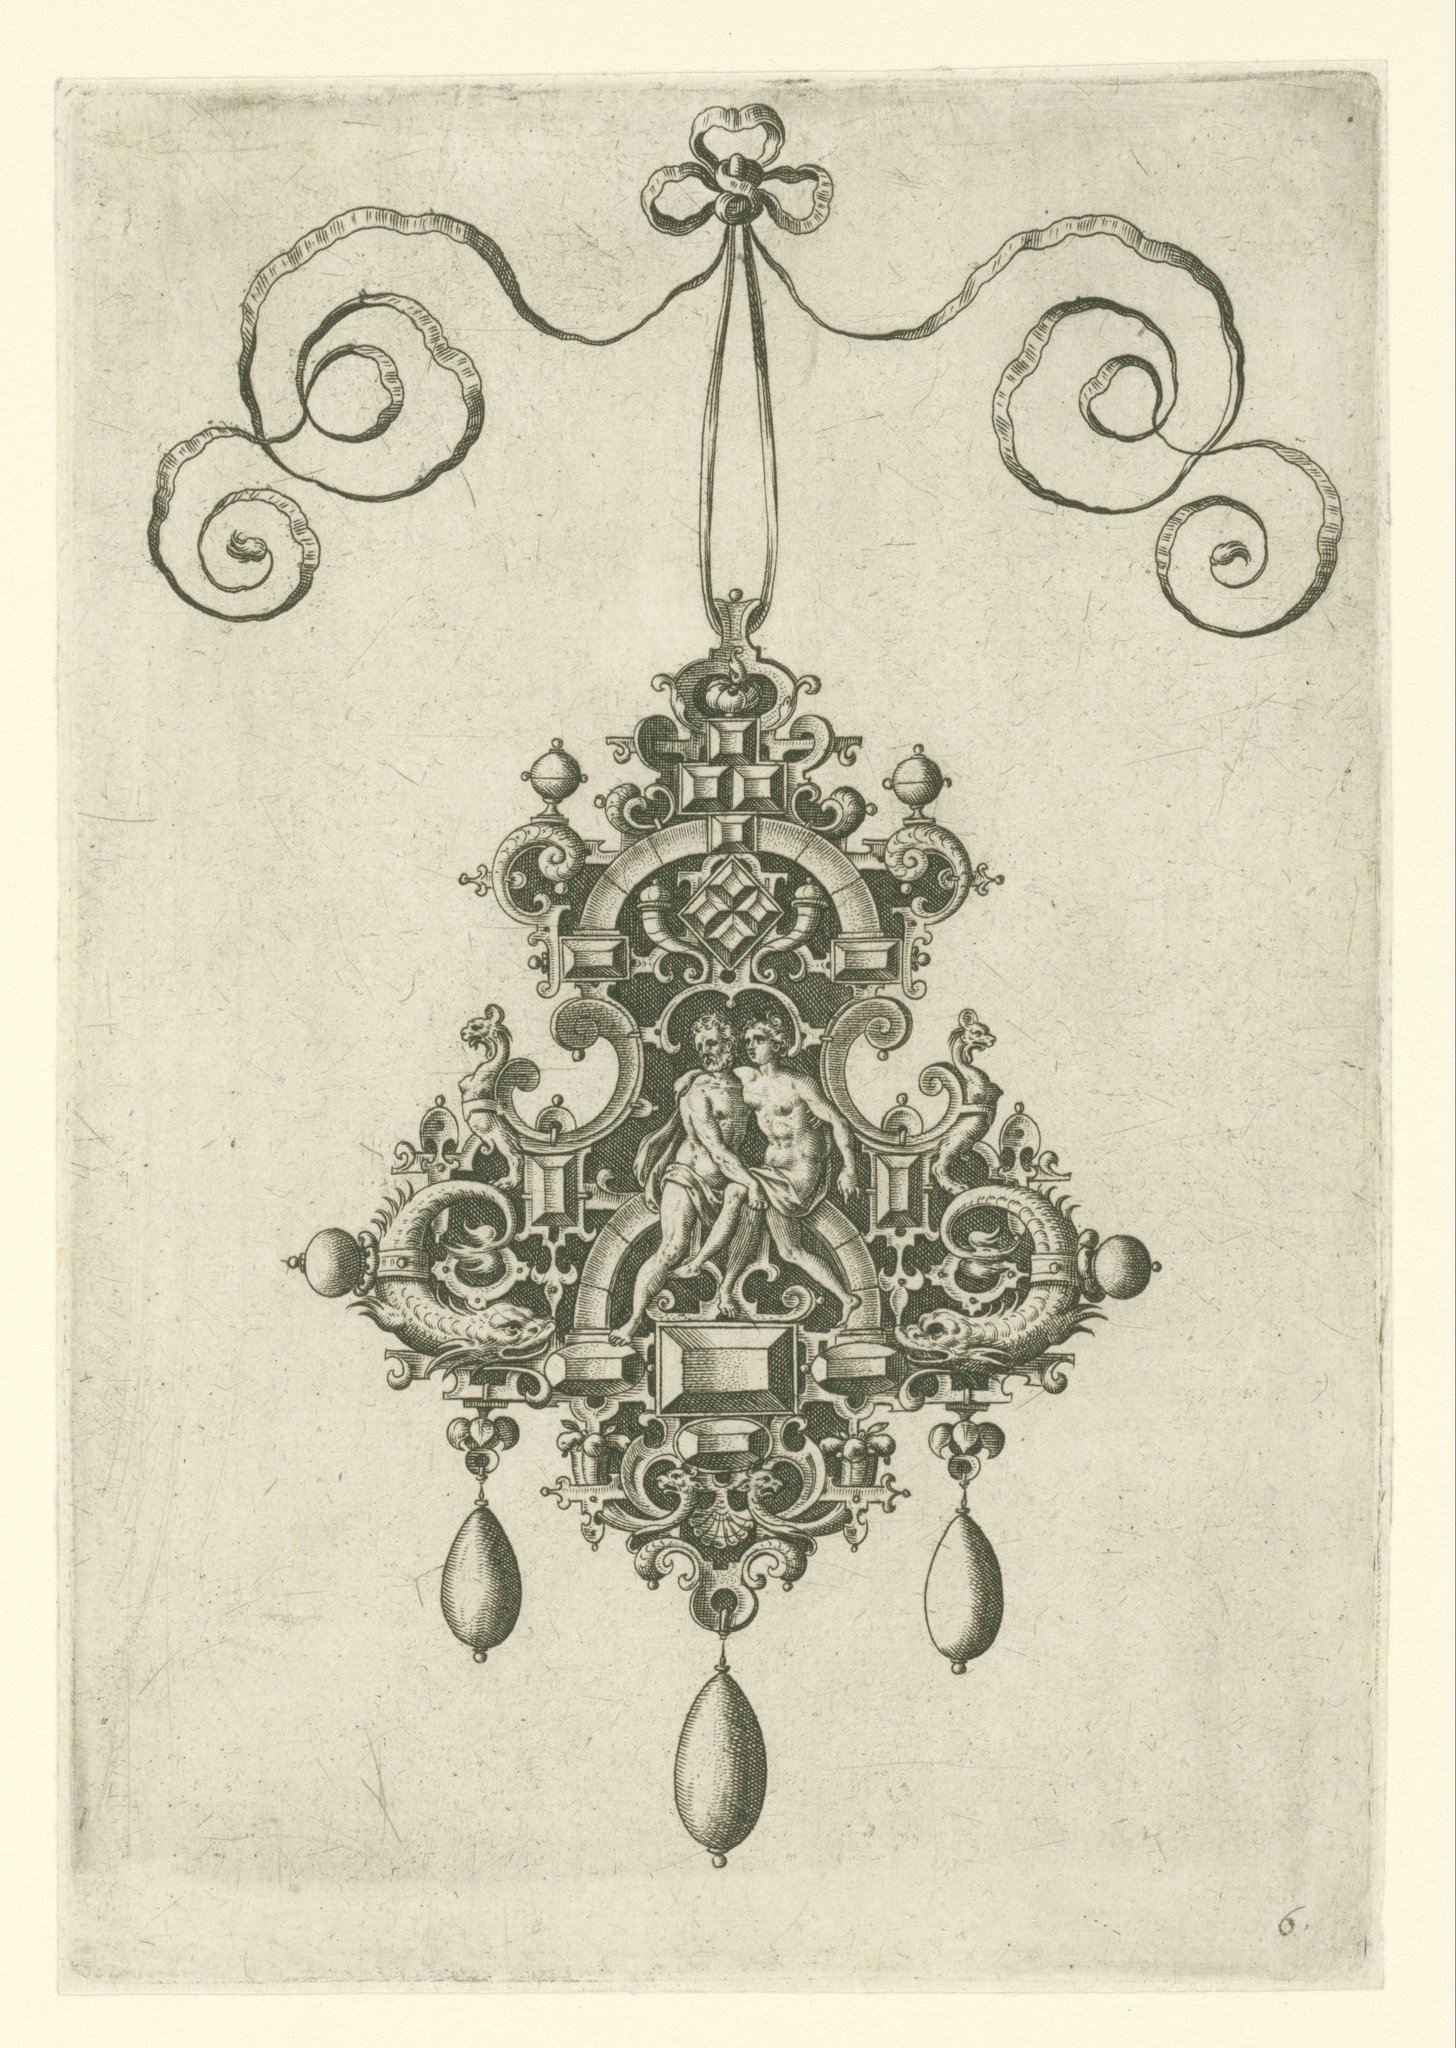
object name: ornament print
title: Hanger met liefdespaar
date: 1581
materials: paper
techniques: engraving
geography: netherlands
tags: pendant, trinket, 'breloque'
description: Blad 6 van 10 Bladen met ornamentontwerpen, Antwerpen 1581. W. 20